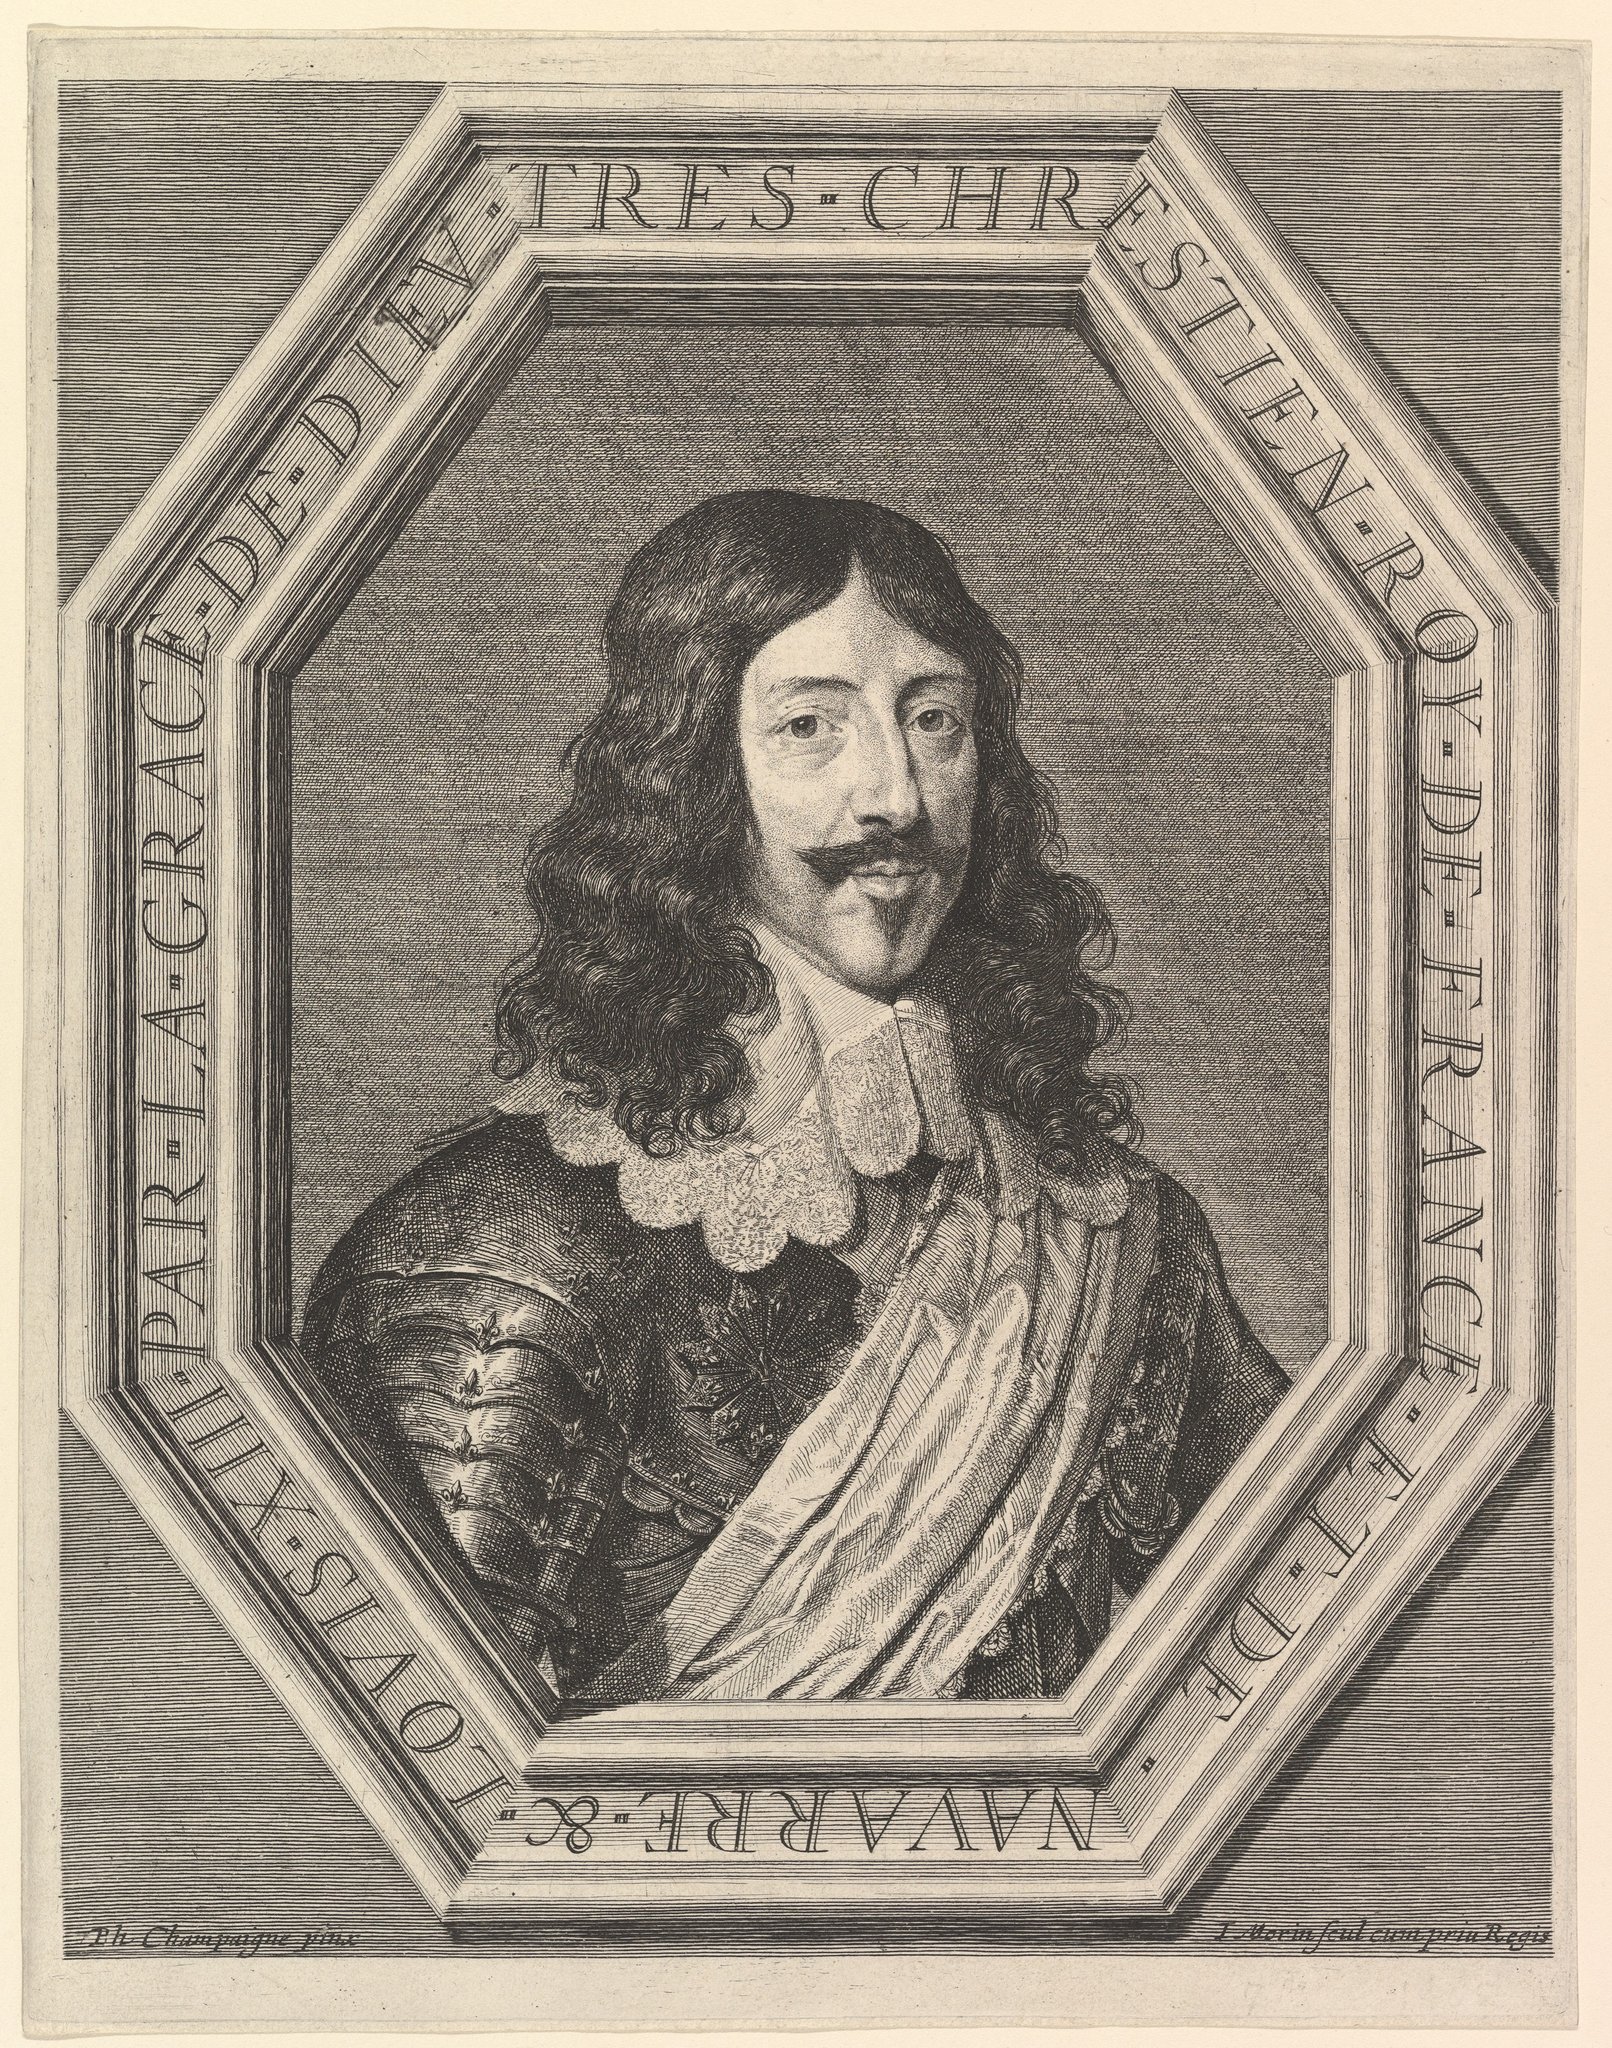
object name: print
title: Louis XIII, roi de France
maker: jean morin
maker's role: artist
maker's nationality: french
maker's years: 1605-1650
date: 1605-1650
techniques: etching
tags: kings,portraits